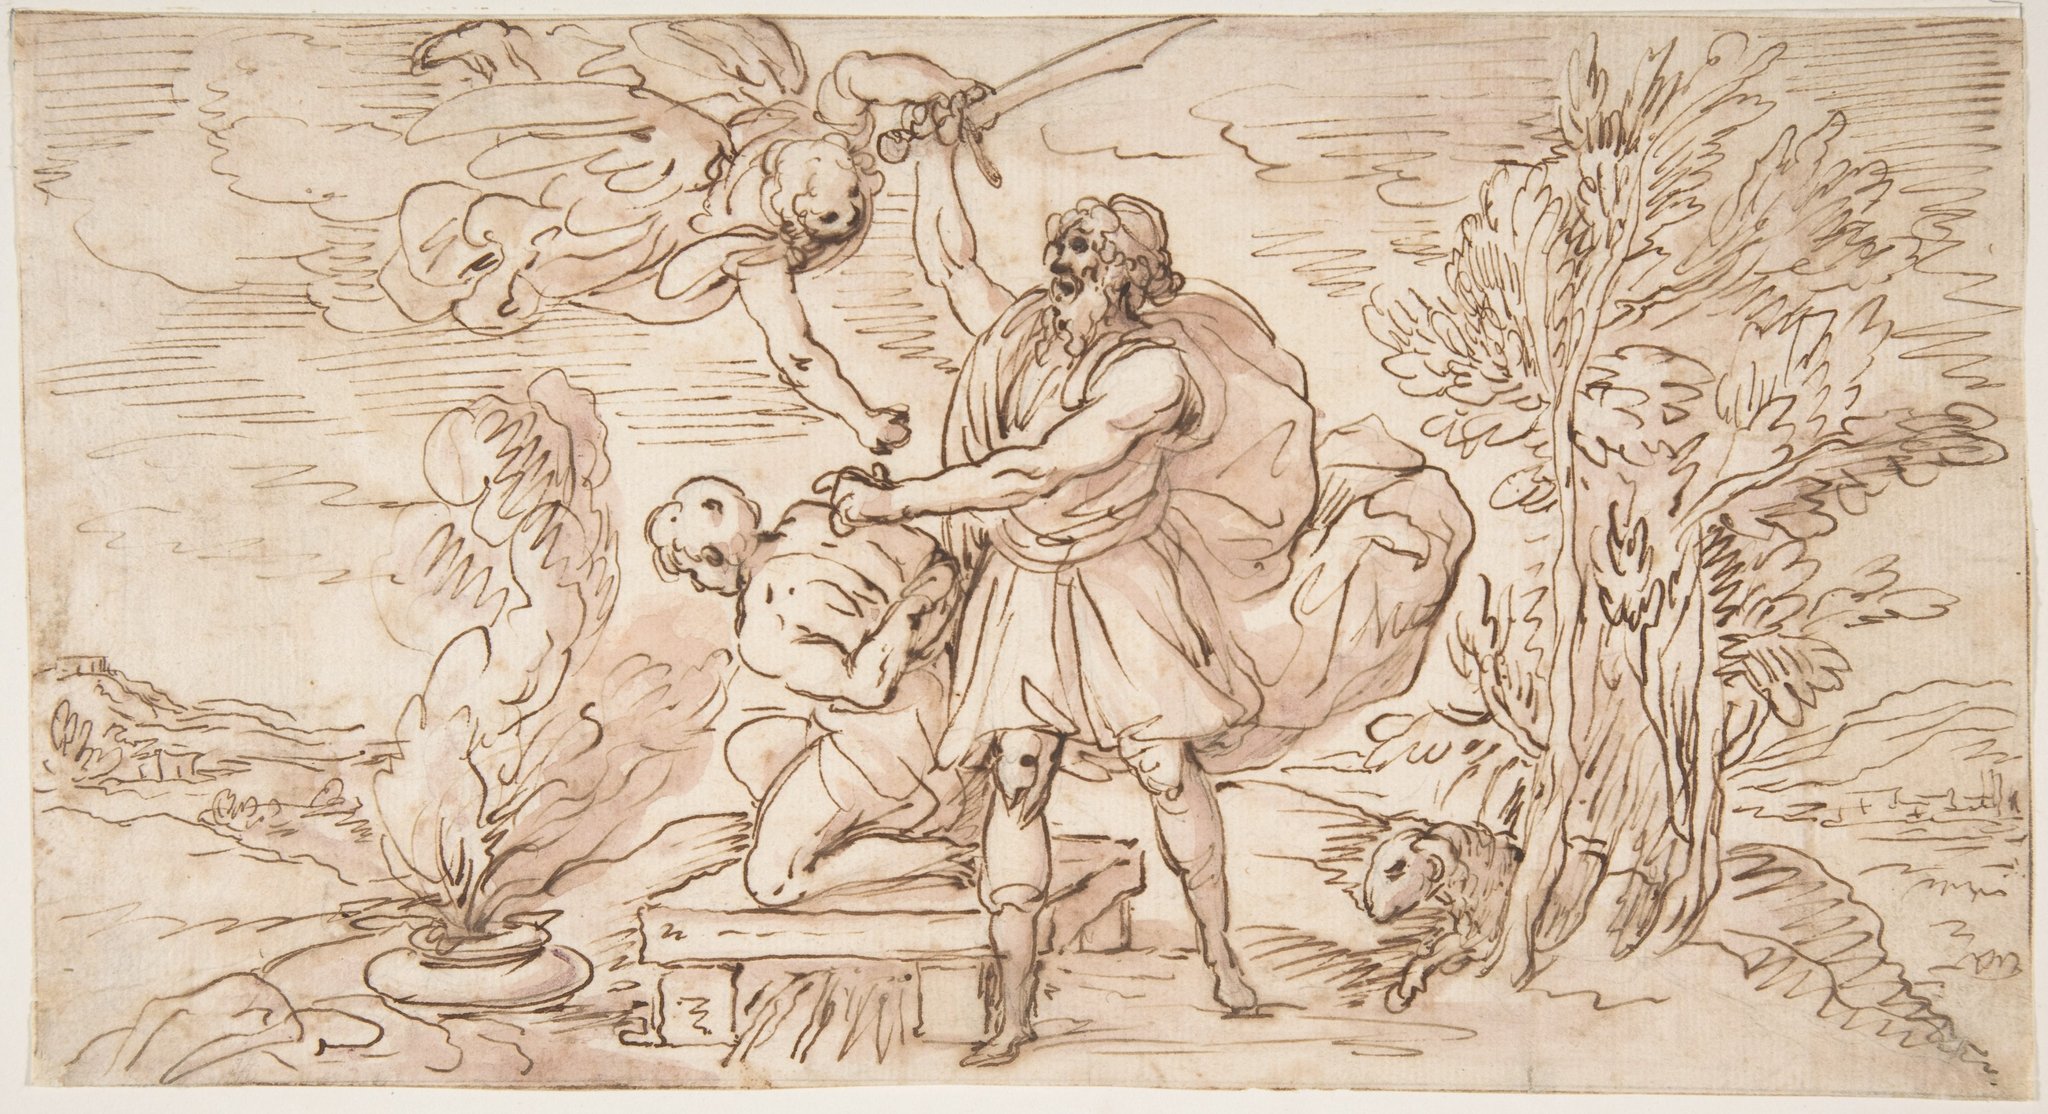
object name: drawing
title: Abraham about to Sacrifice Isaac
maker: micco spadaro (domenico gargiulo)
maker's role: artist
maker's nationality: italian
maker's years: 1609-1675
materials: ink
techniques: brush, pen, wash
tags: angels,abraham,isaac